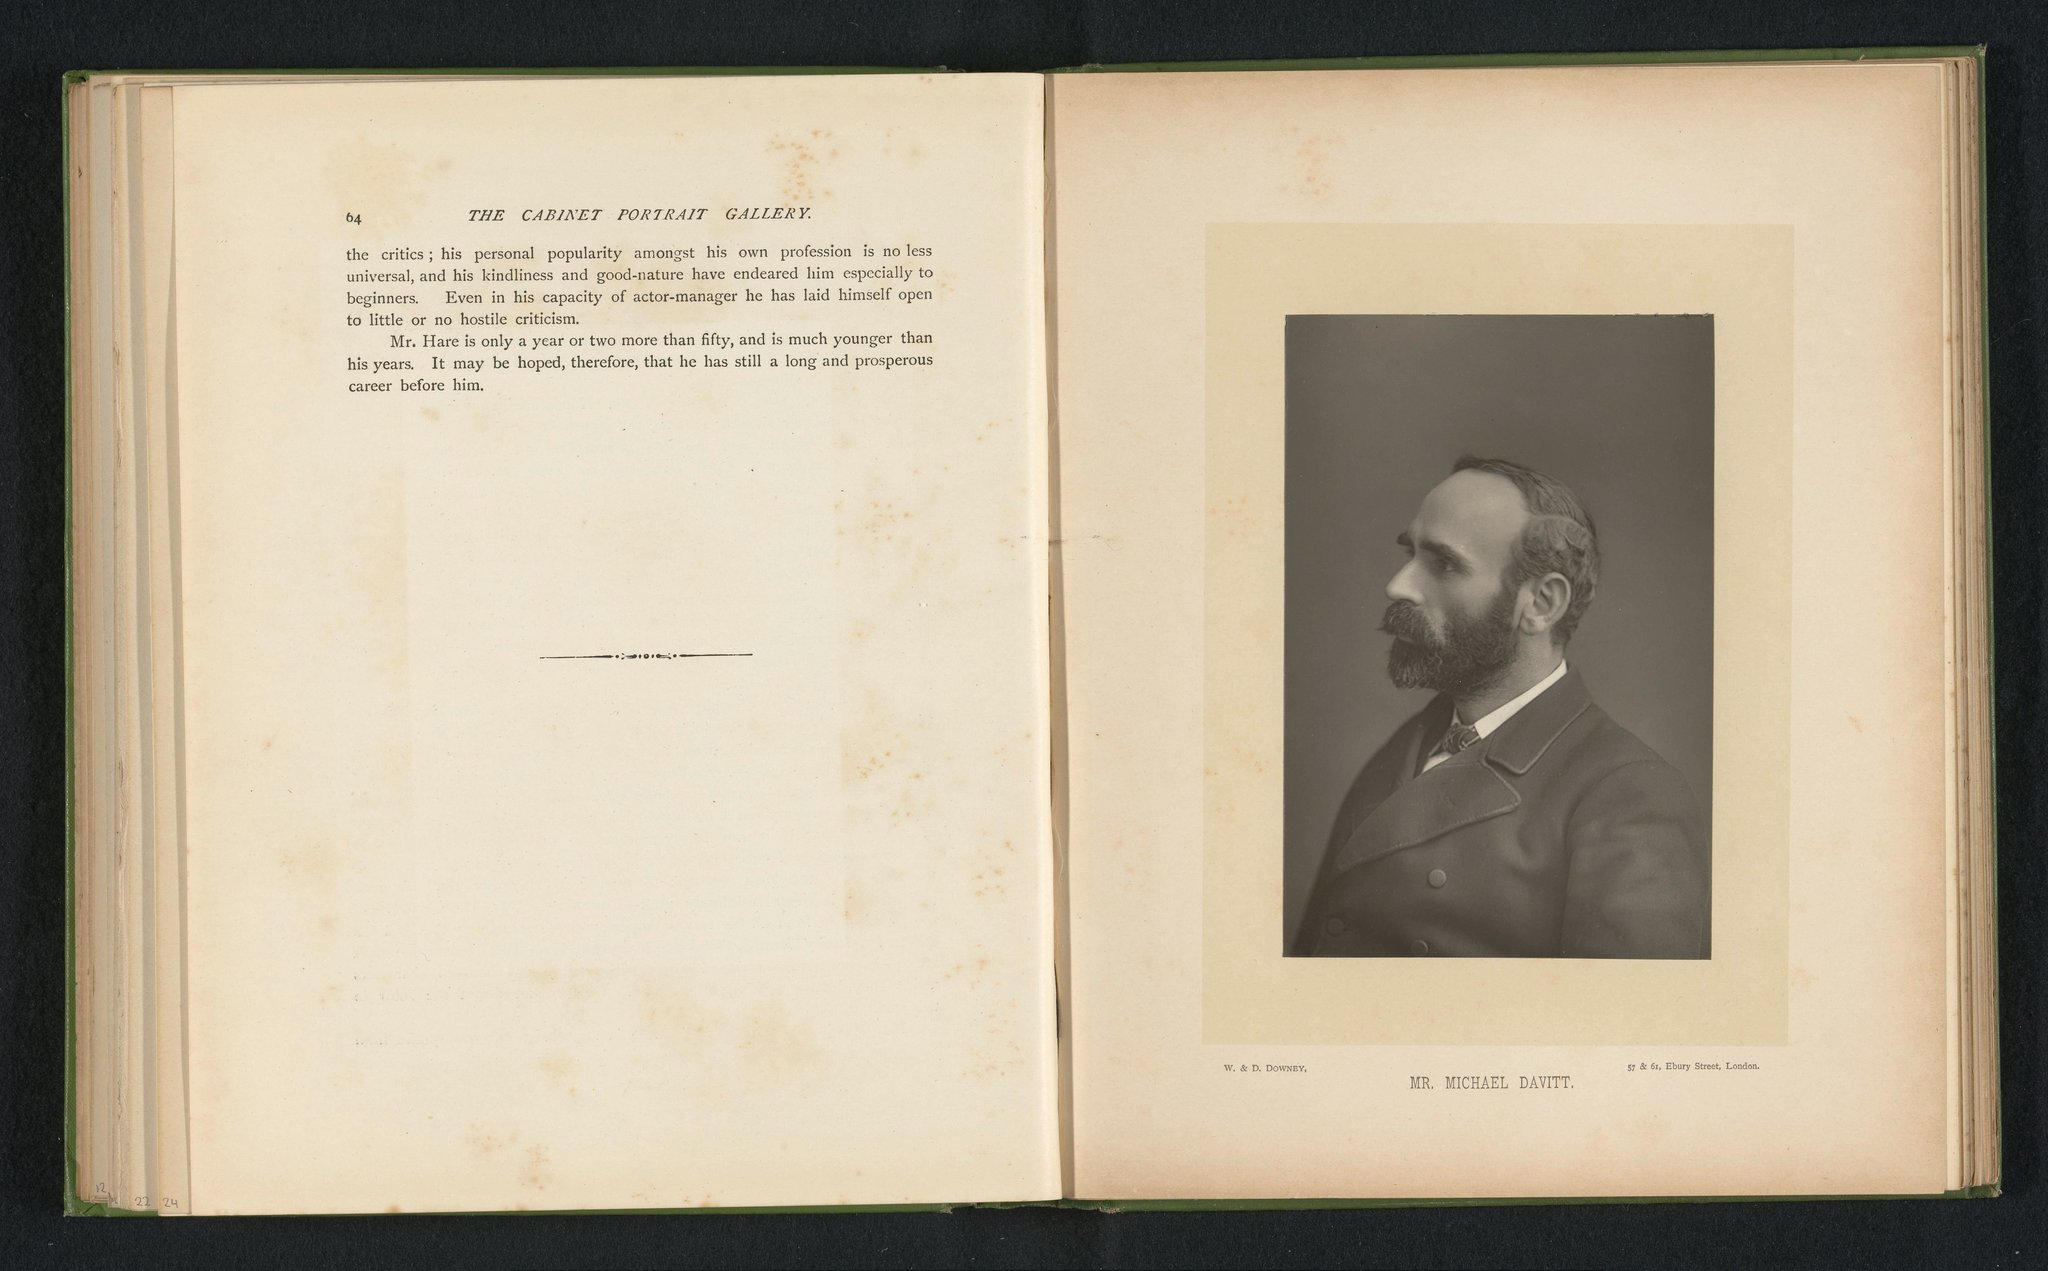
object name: photomechanical print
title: Mr. Michael Davitt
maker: Anonymous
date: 1884-1894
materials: paper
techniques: woodburytype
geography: london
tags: politician, revolutionary council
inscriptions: inscription: ‘57 & 61, Elbury Street, London.’